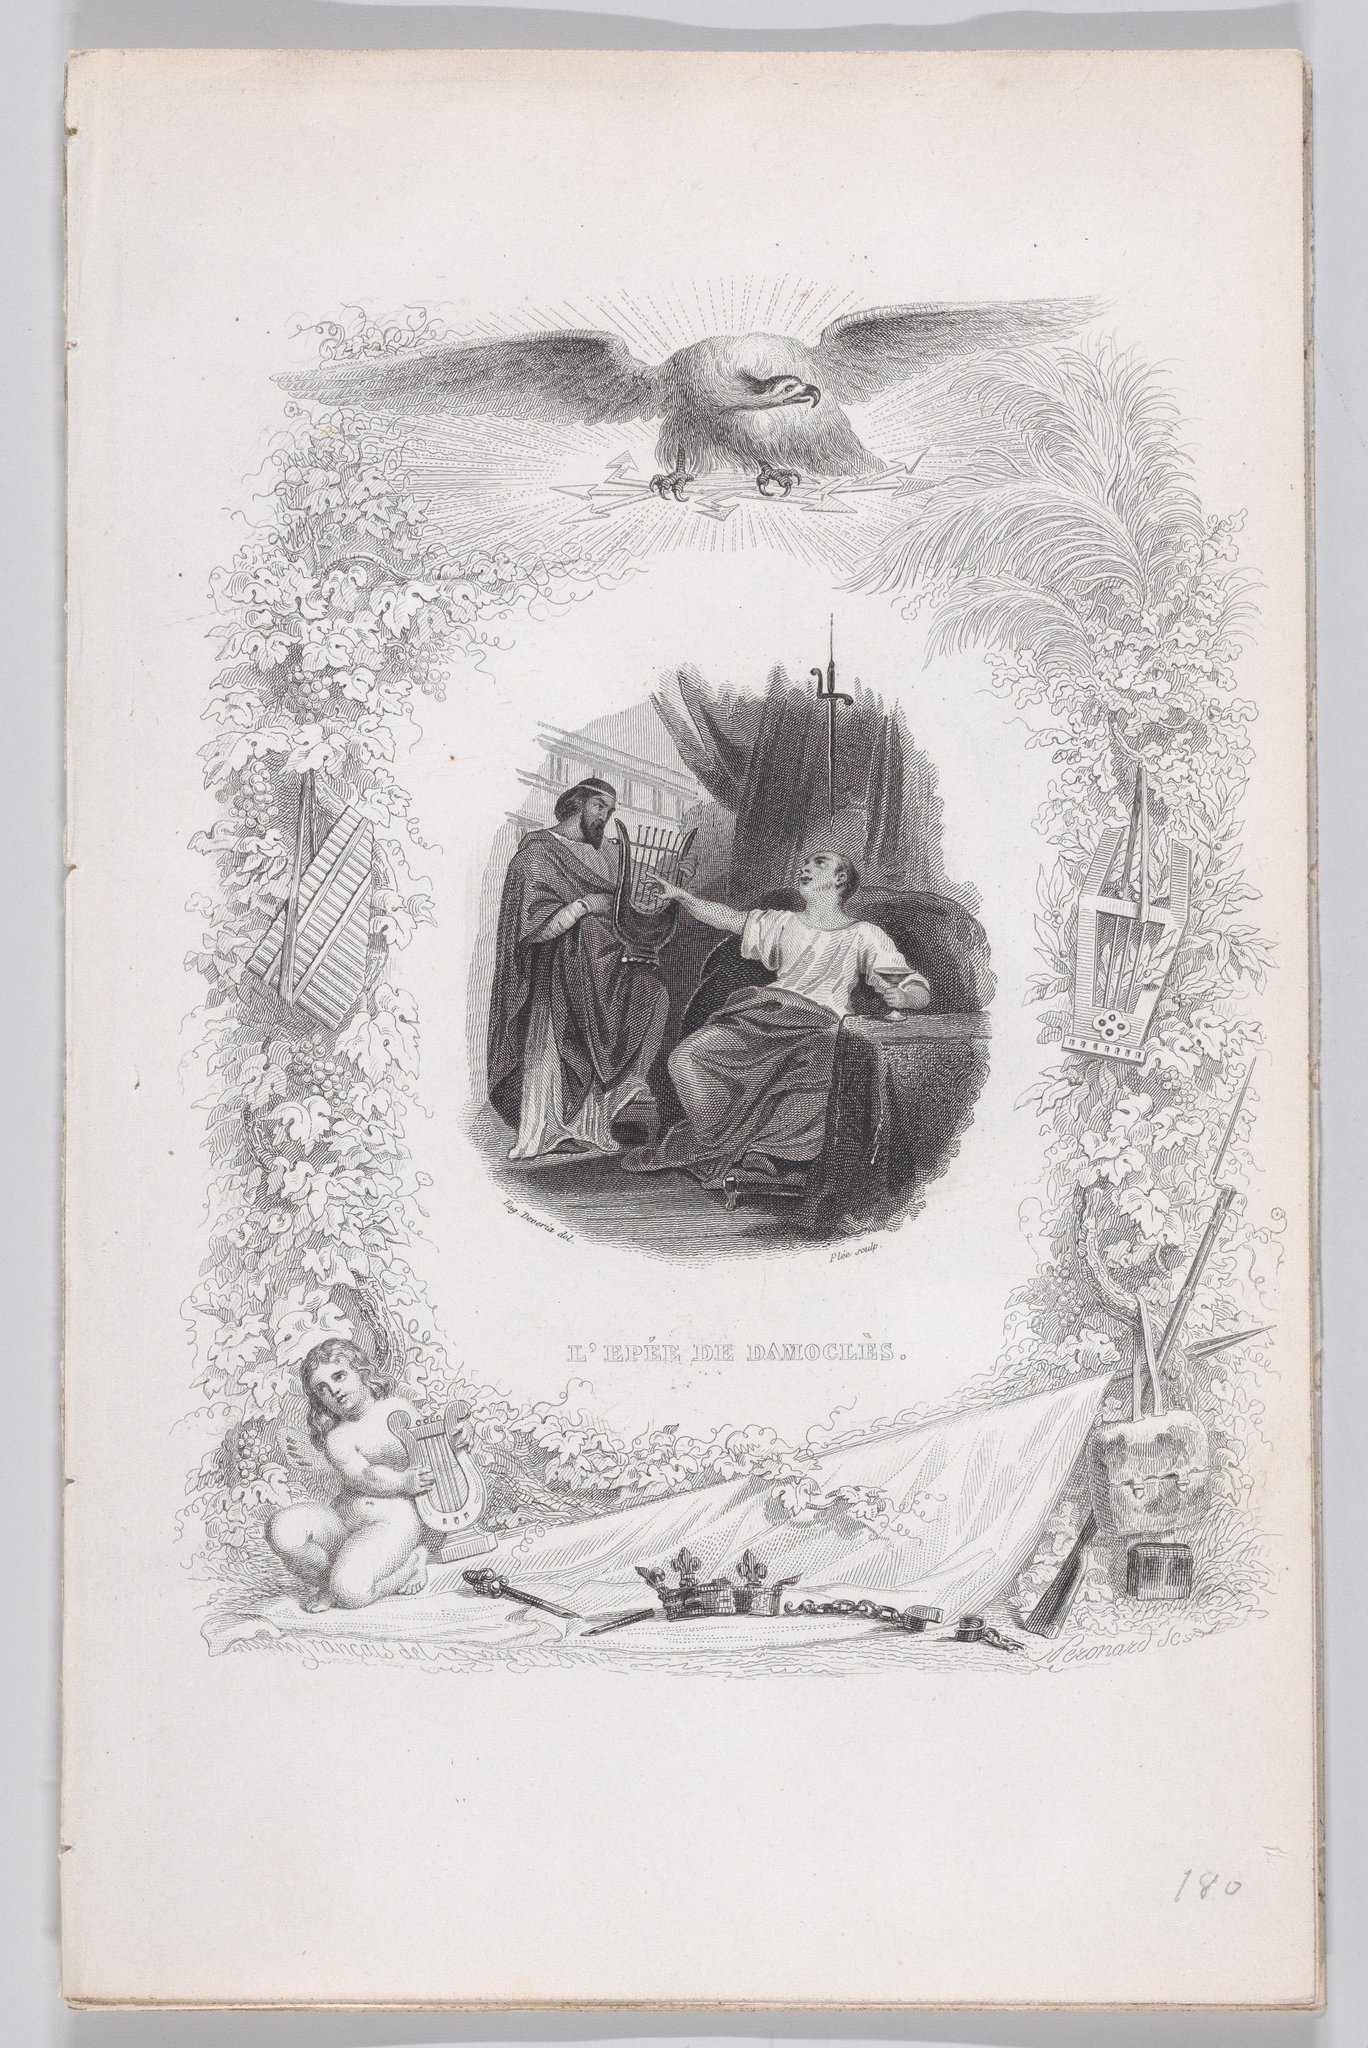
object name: print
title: The Sword of Damocles, from "The Songs of Béranger"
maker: eugène devéria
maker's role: designer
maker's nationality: french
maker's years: 1805-1865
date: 1829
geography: paris